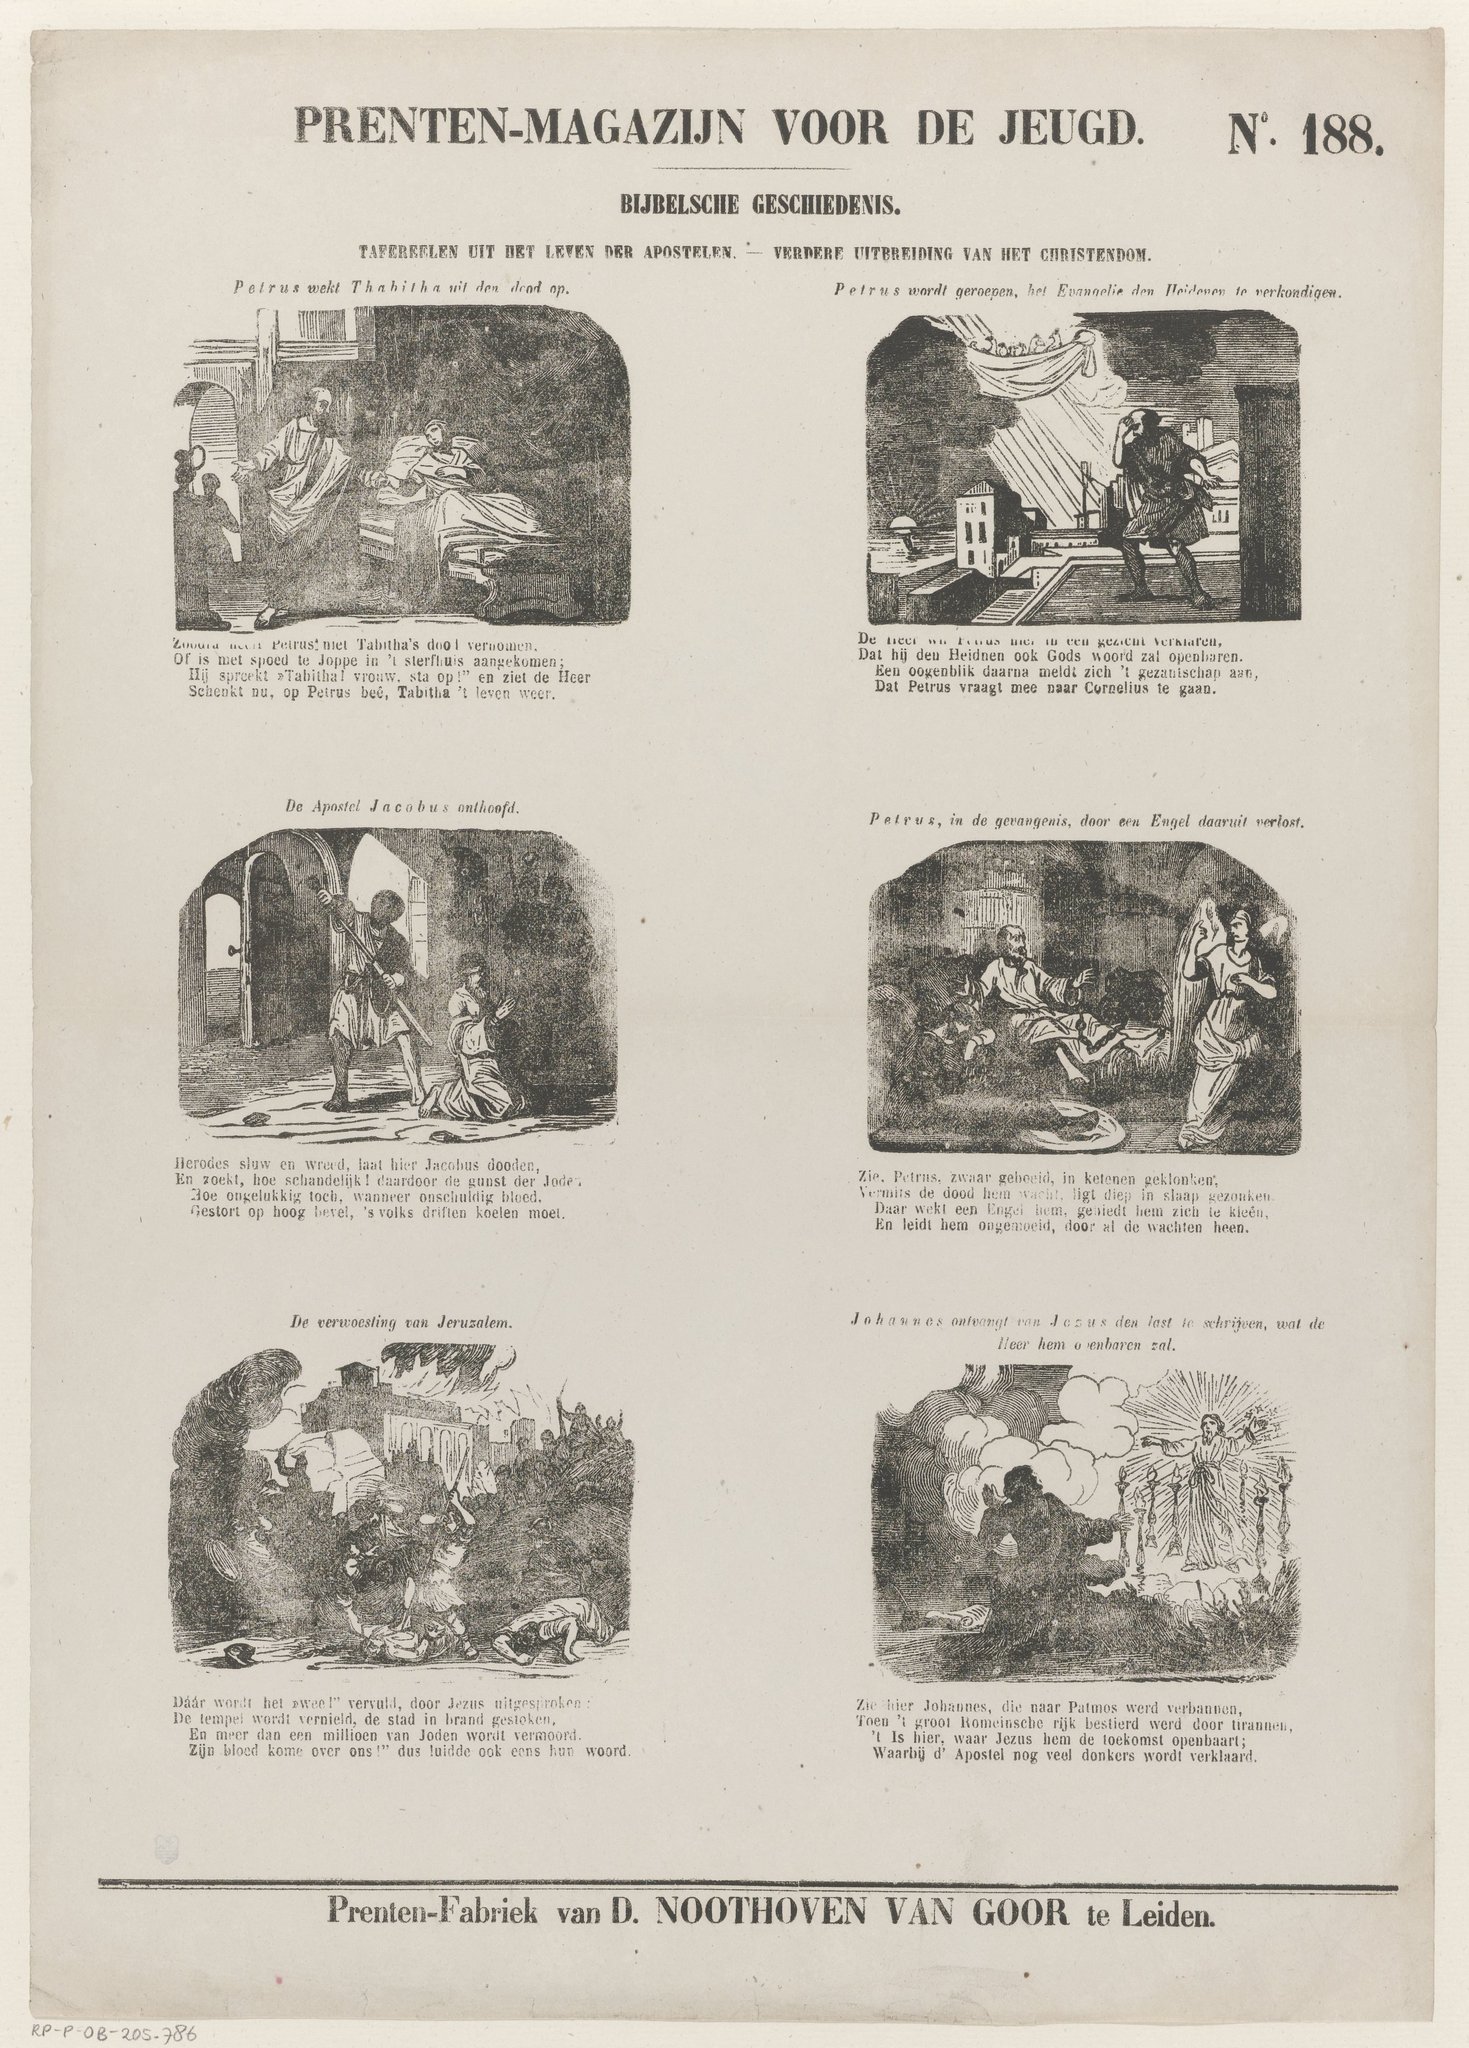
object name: popular print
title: Bijbelsche geschiedenis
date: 1850-1881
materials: paper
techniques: letterpress printing, engraving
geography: netherlands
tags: the fall of jerusalem ~ story of zedekiah, calling of peter and andrew (john 1:40-42), an angel appears, summoning peter to wake up ~ peter in prison, an angel sent by christ appears to john on patmos (+ variant), tabitha is raised from the dead by peter's prayer, jacob's death (genesis 49:33, 50:1-14)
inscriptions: collector's mark: Lugt 2760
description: Blad met 6 voorstellingen van verhalen over de apostelen Petrus, Jacobus en Johannes. Boven elke afbeelding een titel, onder elke afbeelding een vierregelig vers. Genummerd rechtsboven: No. 188.